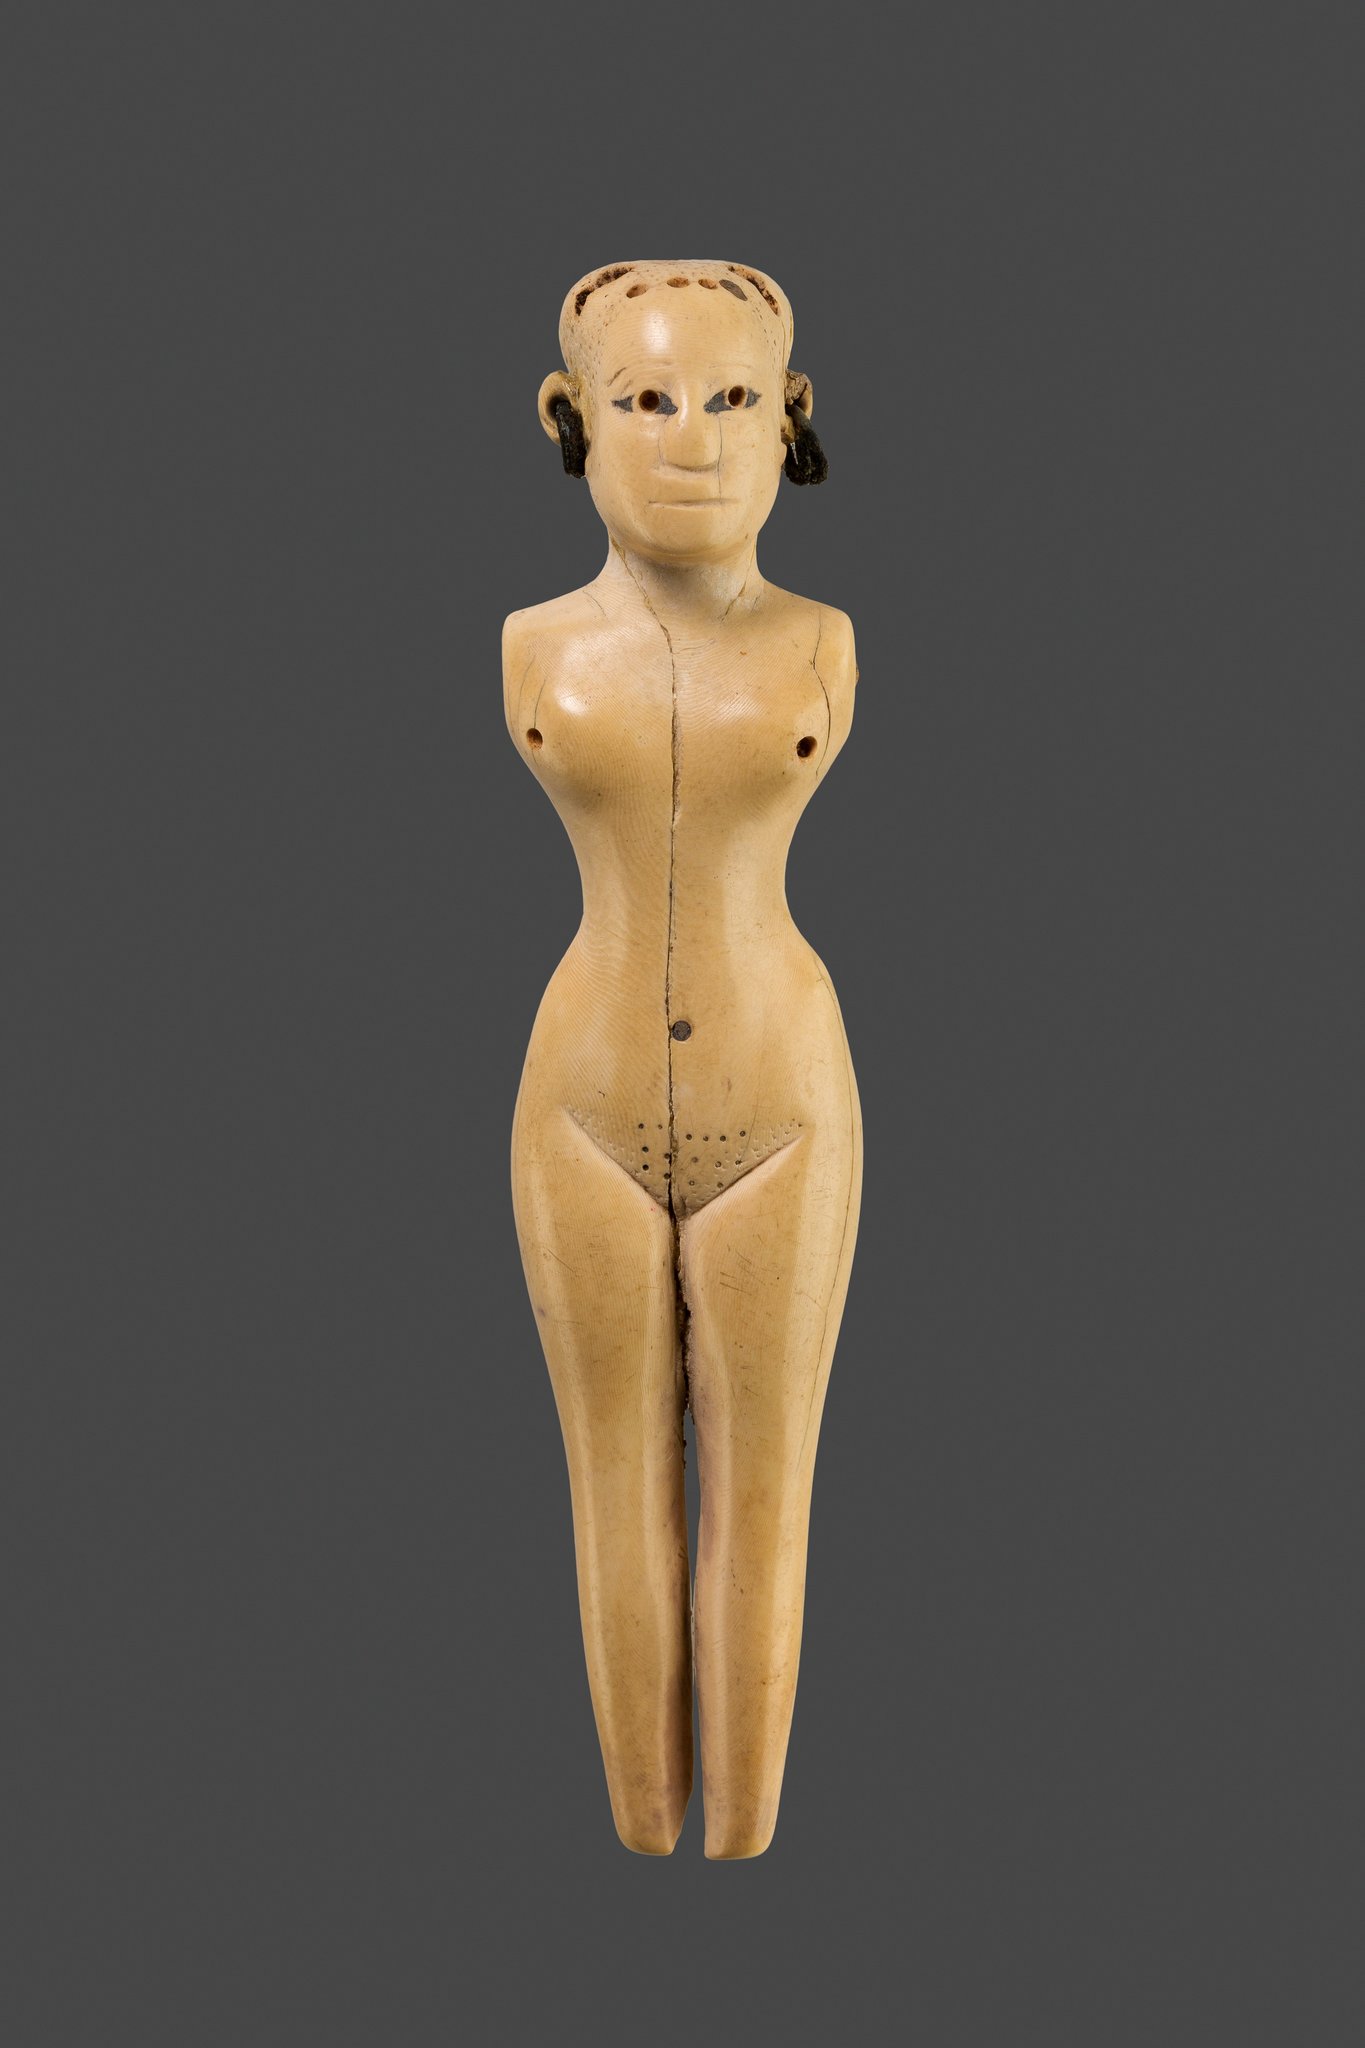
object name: statuette, nude woman, armless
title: Female Figurine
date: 1981-1550 BCE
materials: bronze, ivory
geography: egypt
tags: female nudes